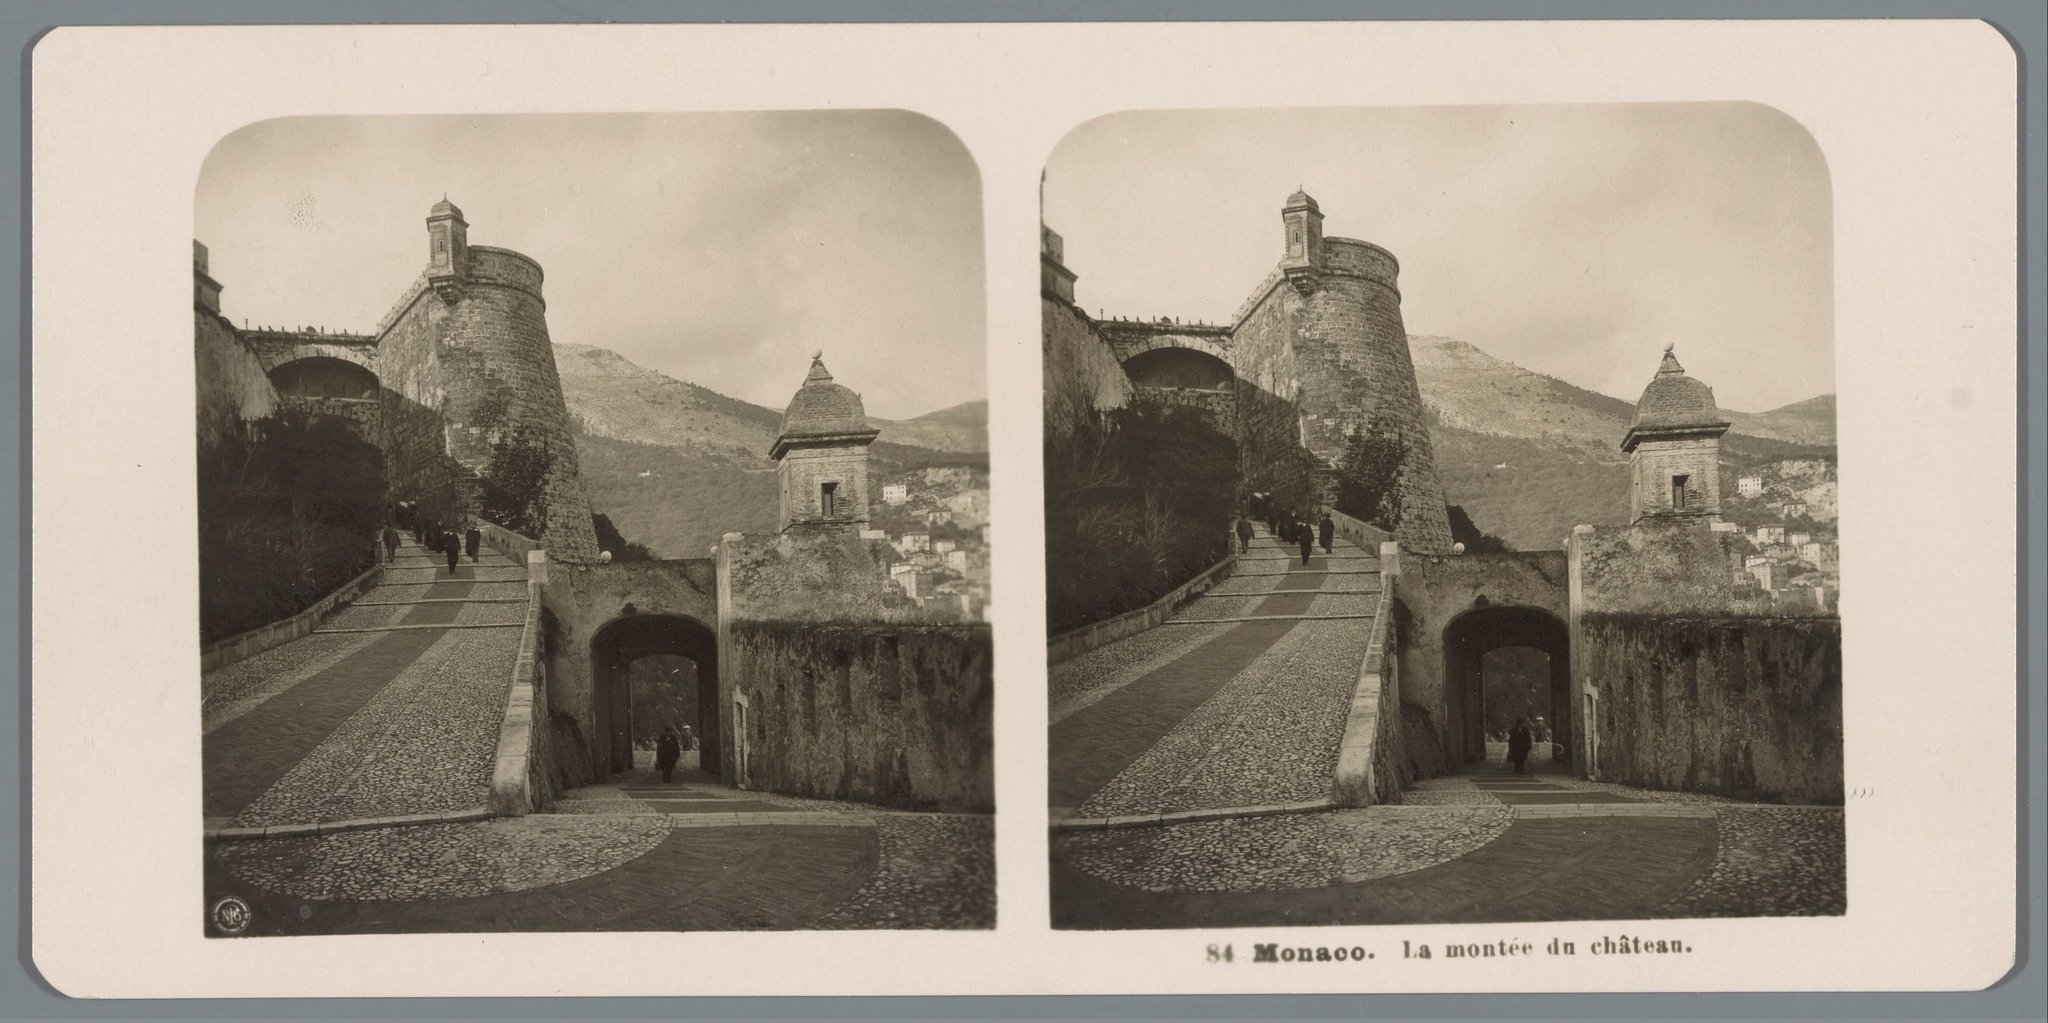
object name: stereograph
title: Monaco. La montée du château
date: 1900-1910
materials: cardboard, photographic support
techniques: gelatin silver print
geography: monaco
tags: sloping street; street with steps or stairs, palace, façade (of house or building)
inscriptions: inscription: ‘NPG’, number: ‘84’